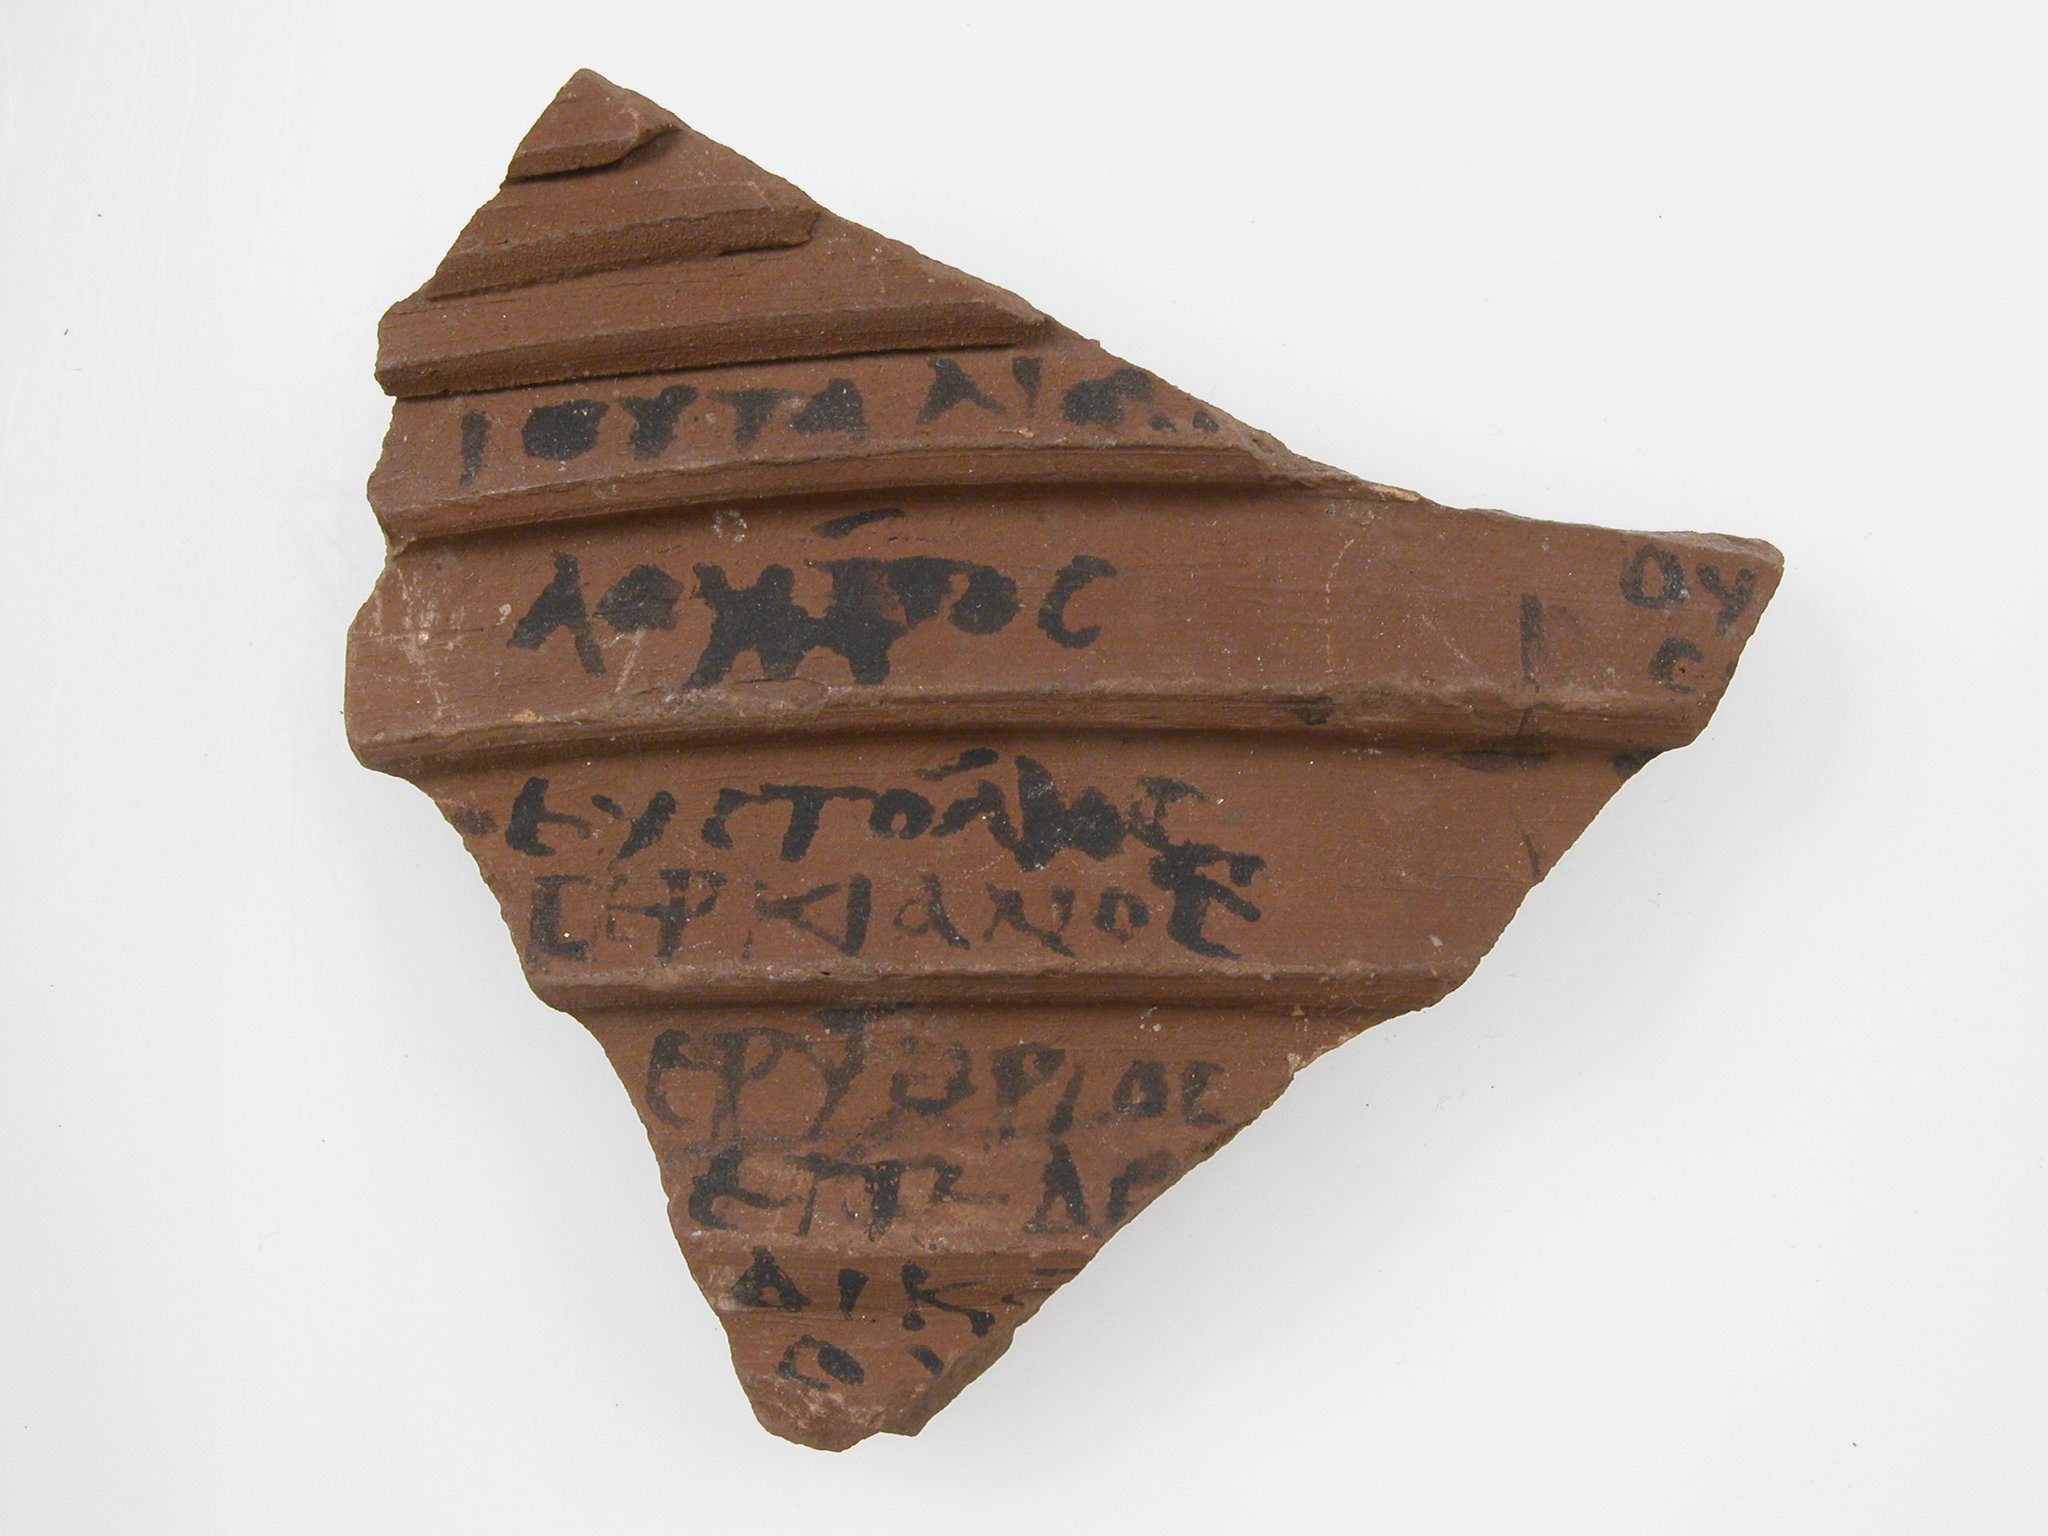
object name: ostrakon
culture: coptic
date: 601-700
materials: ink, pottery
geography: egypt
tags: documents